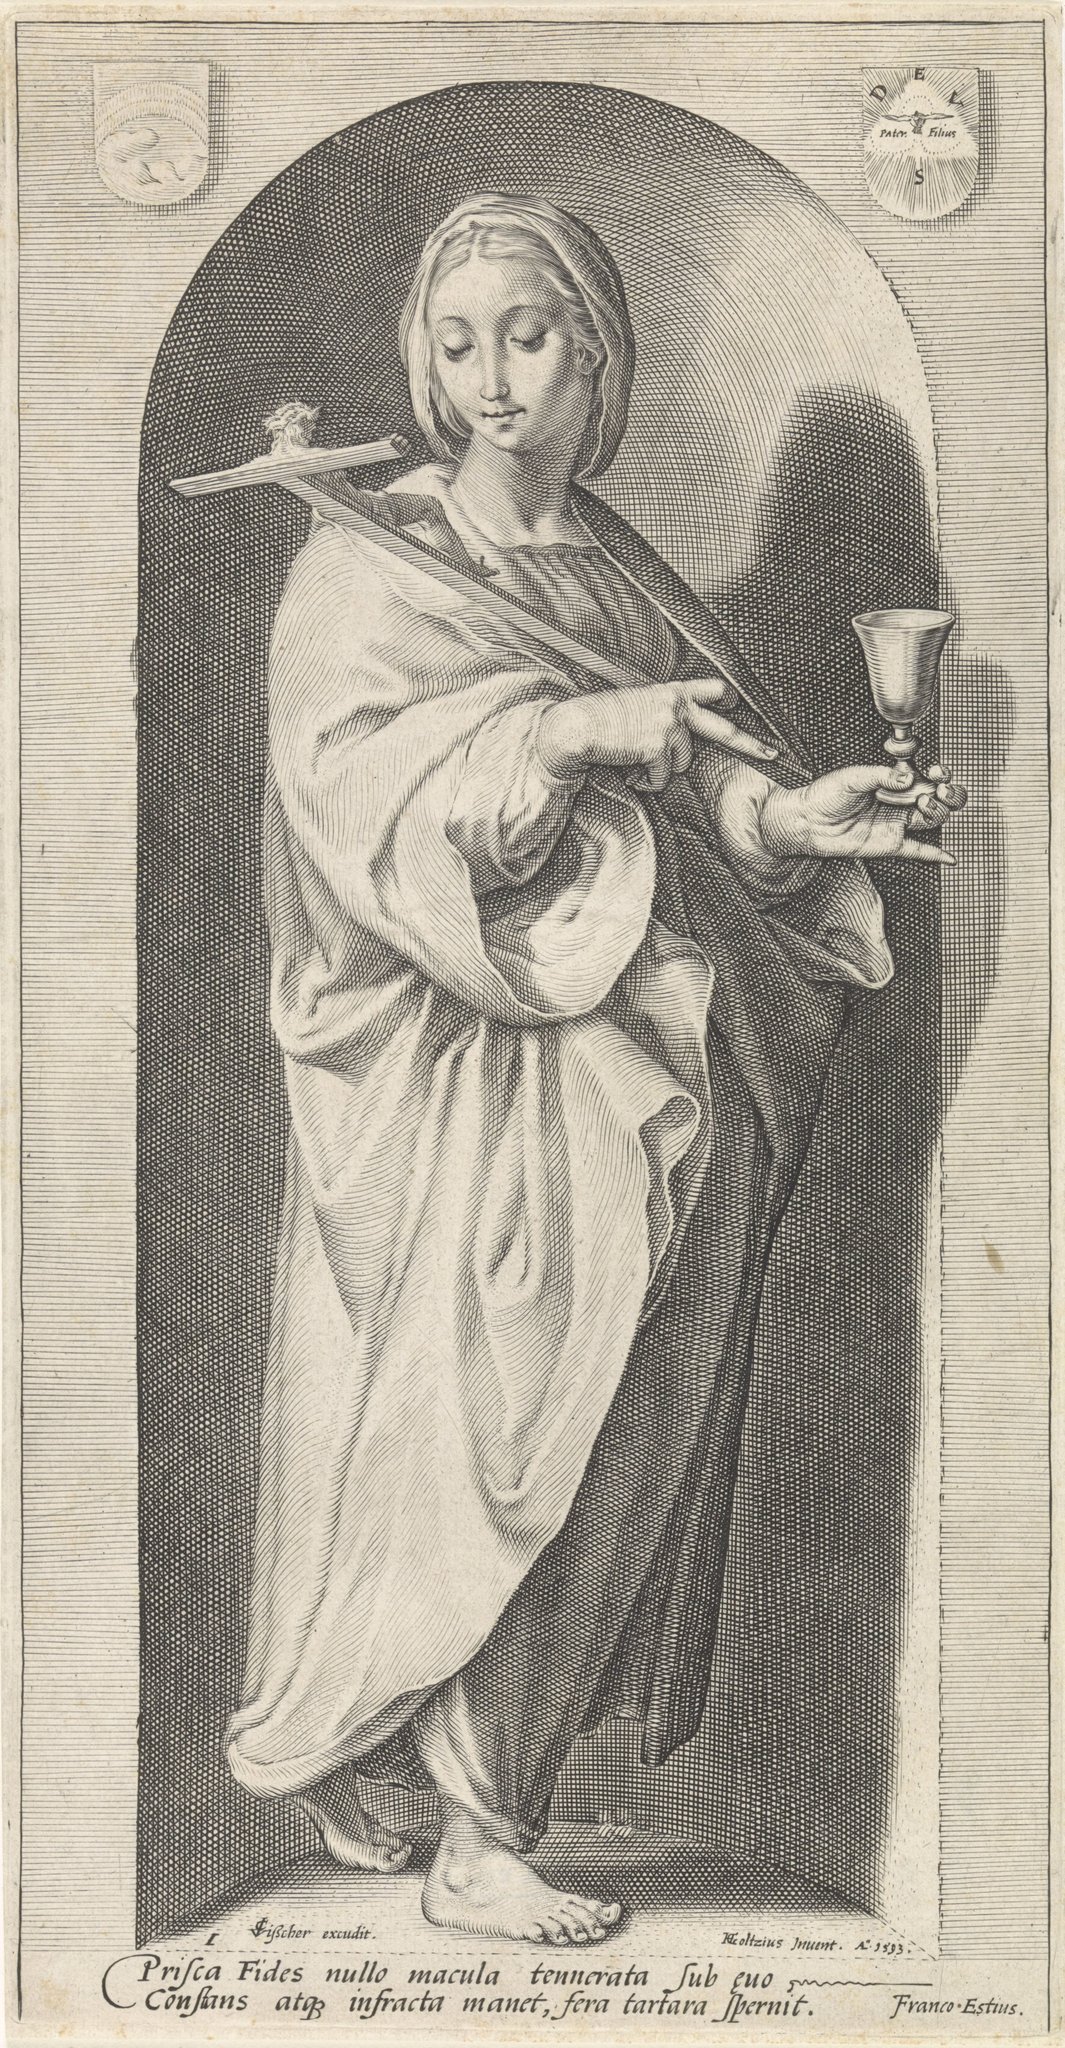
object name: print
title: Geloof (Fides)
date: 1593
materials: paper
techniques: engraving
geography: haarlem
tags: faith, 'fides'; 'fede', 'fede catholica', 'fede christiana', 'fede christiana catholica' (ripa) ~ one of the three theological virtues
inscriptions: collector's mark: Lugt 2228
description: Personificatie van het geloof, met crucifix en kelk, staand in nis.